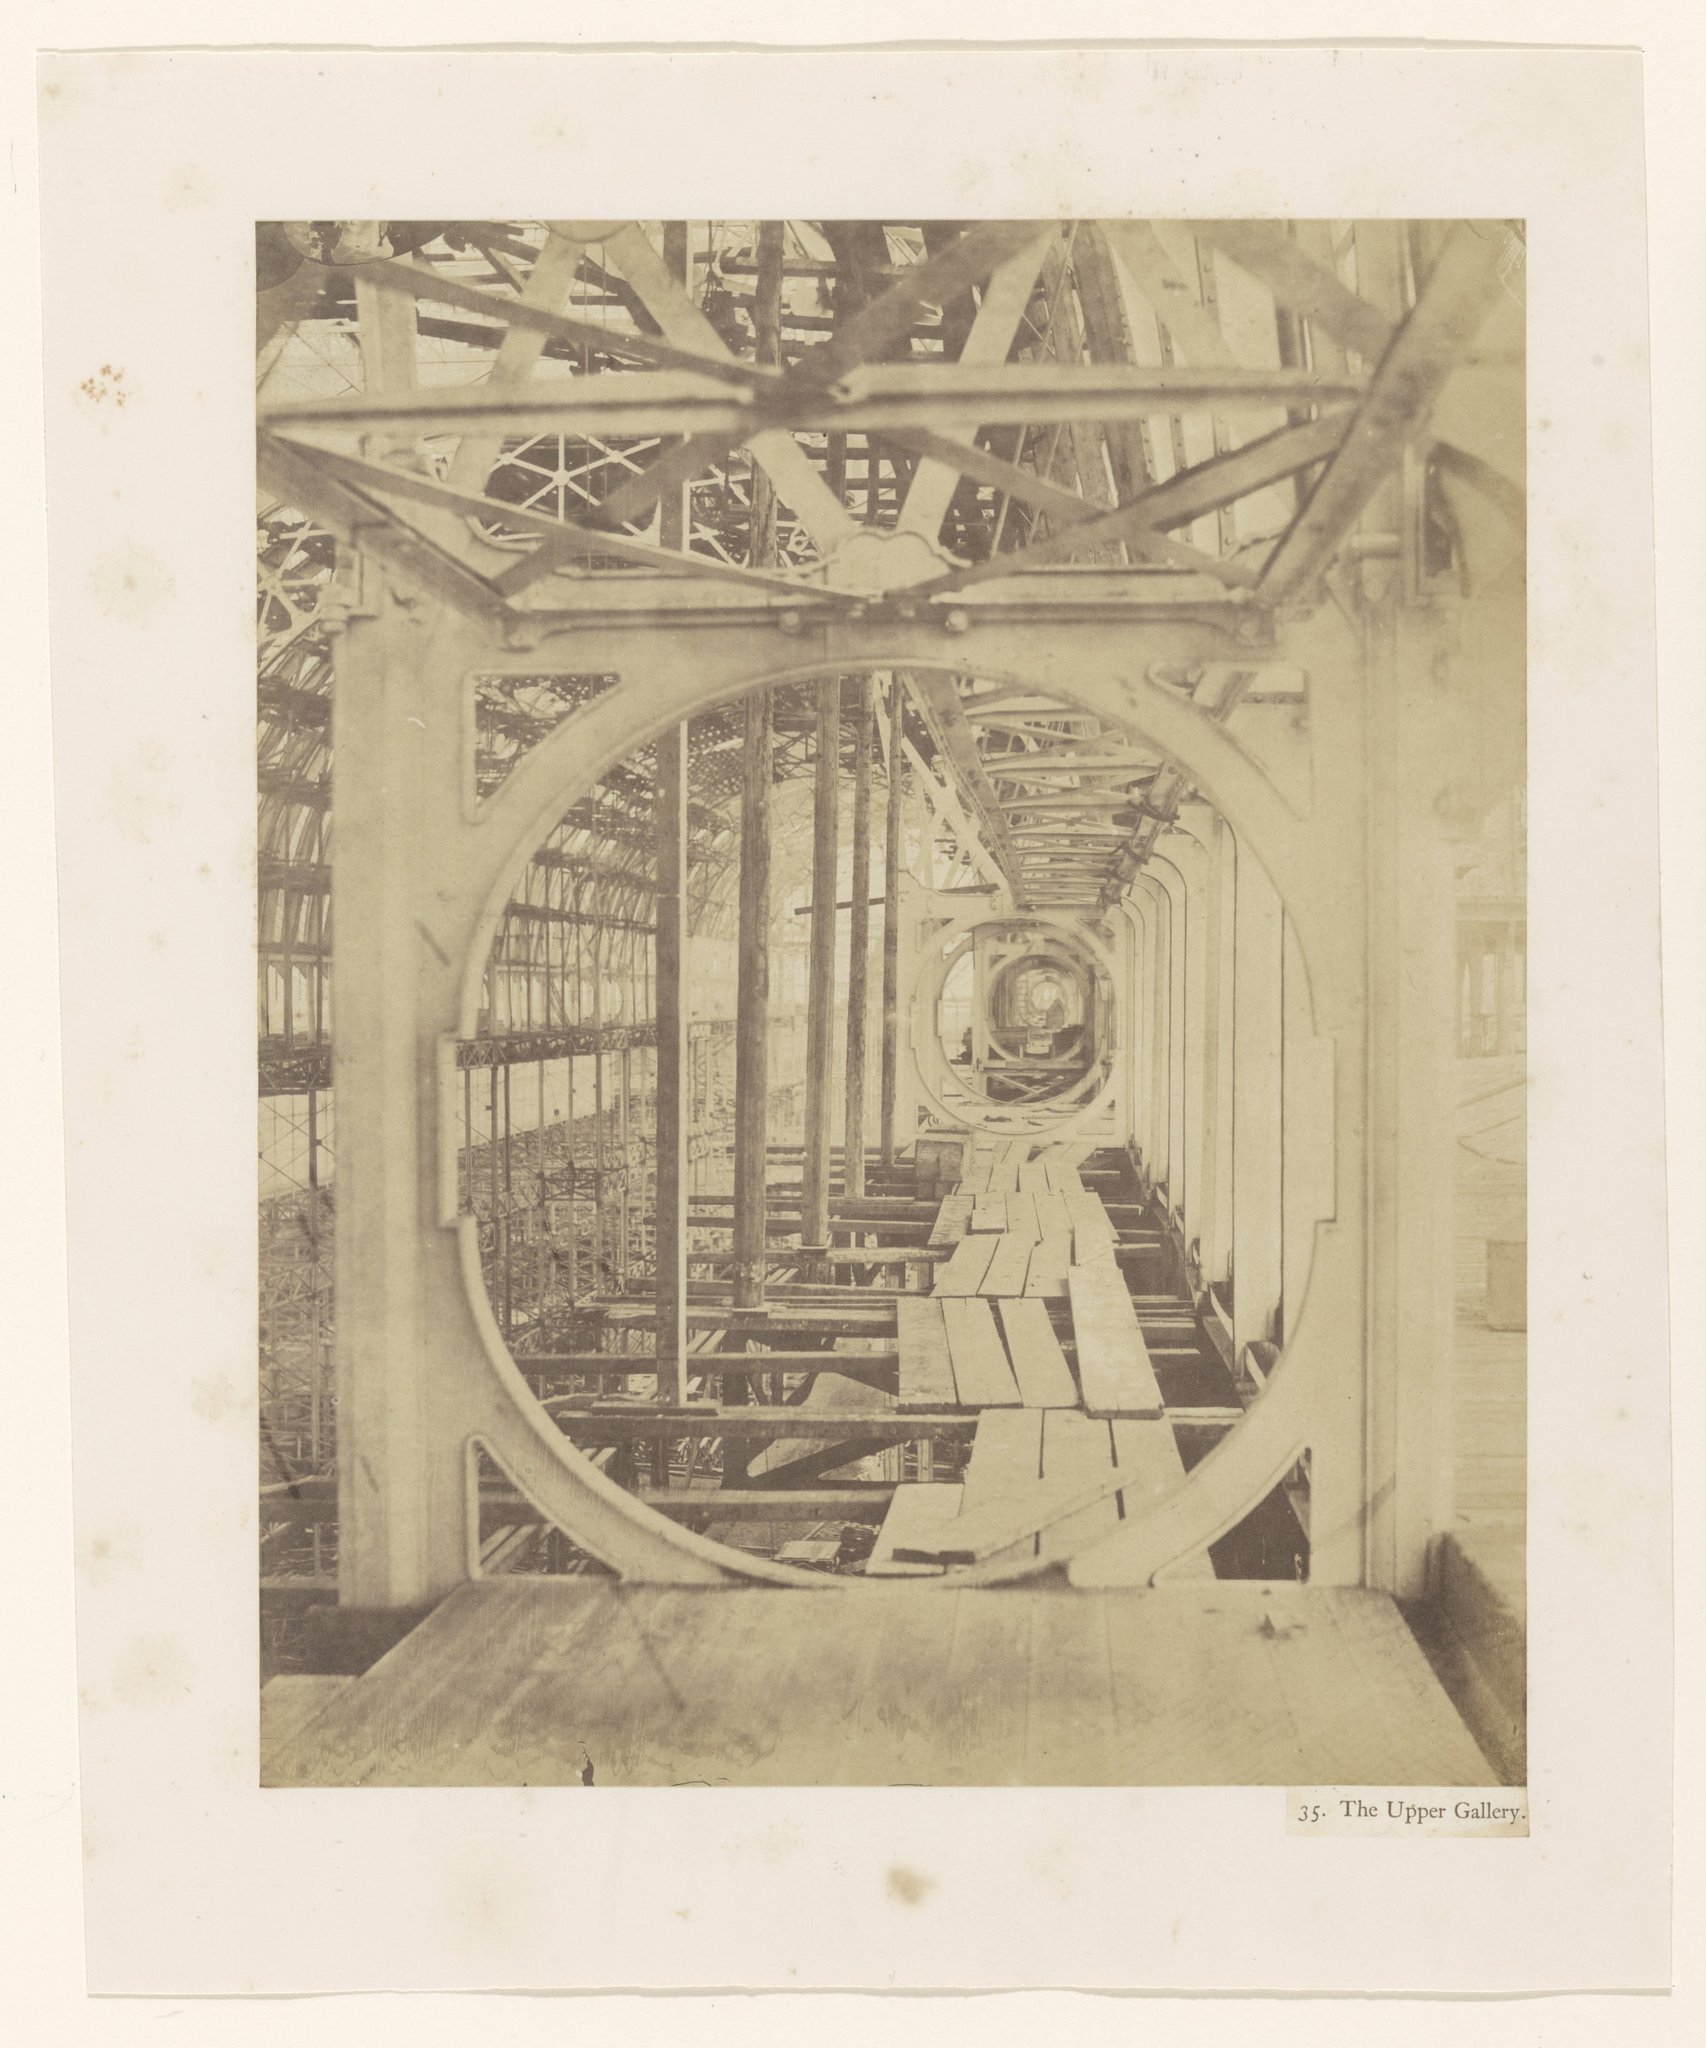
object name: photograph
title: Doorzicht in de bovengalerij van het Crystal Palace in Sydenham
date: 1852-1854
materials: cardboard, photographic support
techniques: salted paper print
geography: great britain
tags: scaffold (~ building activities)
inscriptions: number: ‘35.’